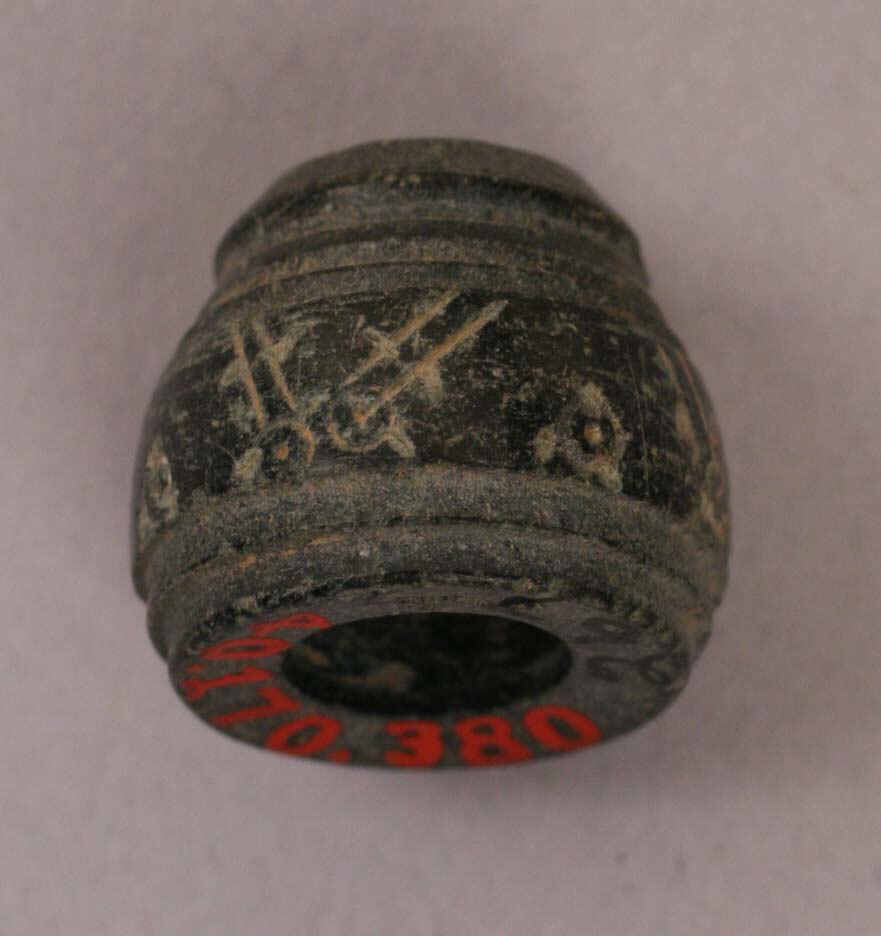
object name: button or bead or spindle whorl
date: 701-1000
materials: stone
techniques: incising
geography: iran